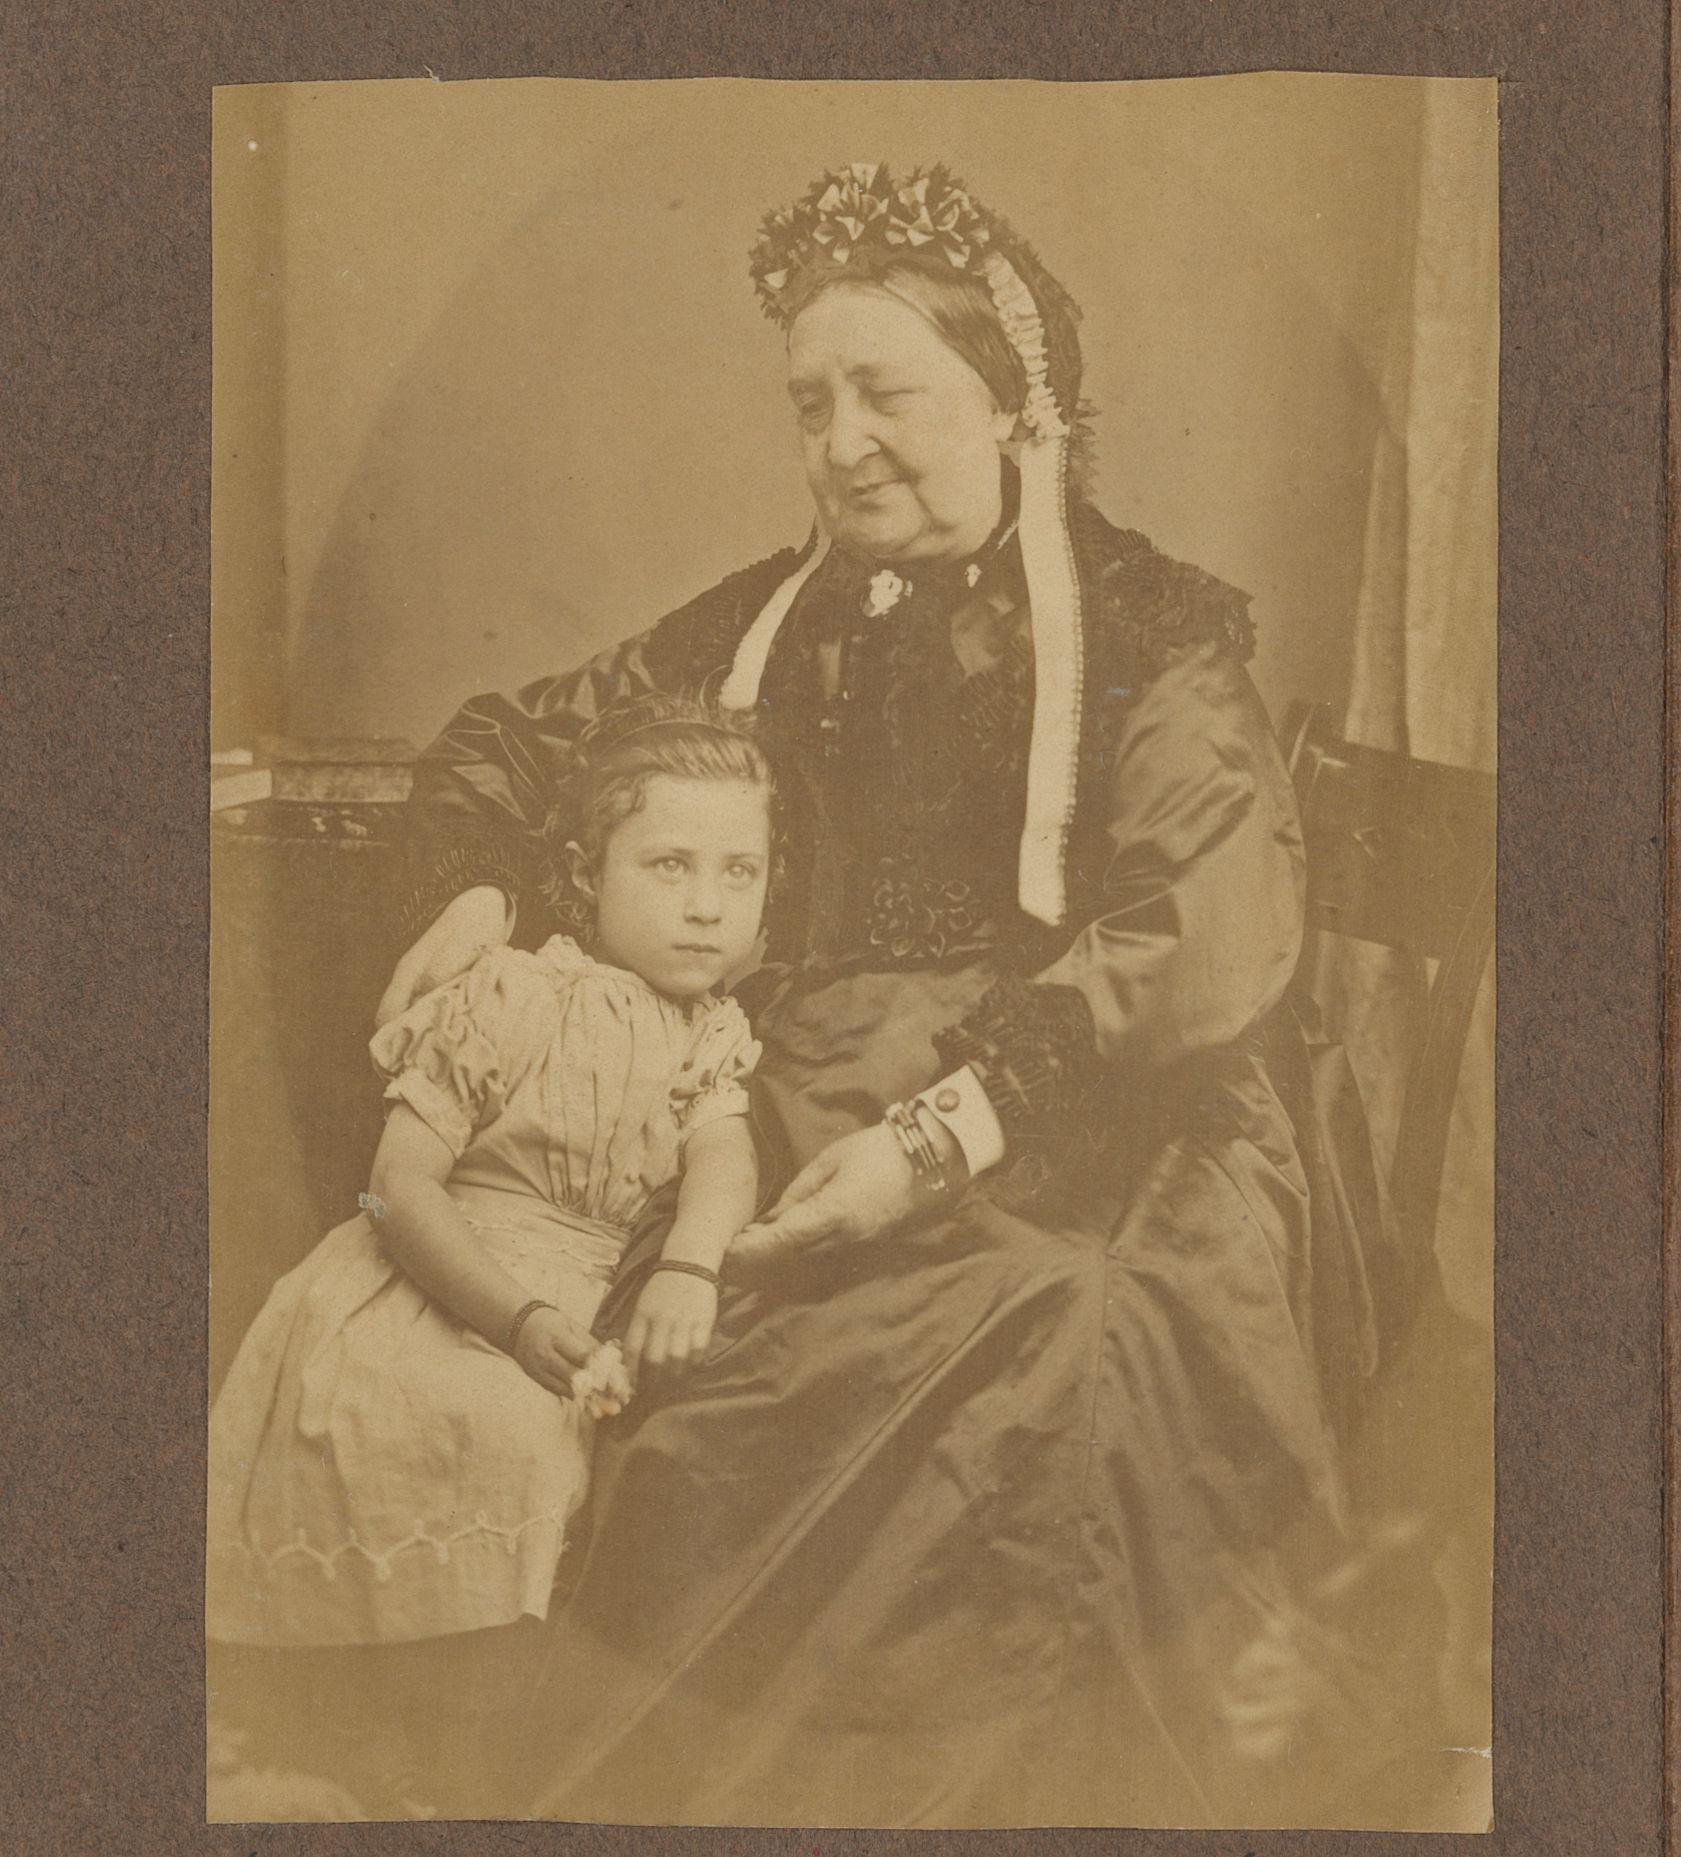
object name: photograph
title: Overgrootmoeder de Jong van Beek en Donk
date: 1869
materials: photographic support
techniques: photography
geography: netherlands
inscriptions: inscription: ‘Overgrootmoeder de Jong van Beek / en Donk / 1869.’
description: Foto op bruin albumblad 20 van familiealbum van Alphons Diepenbrock.